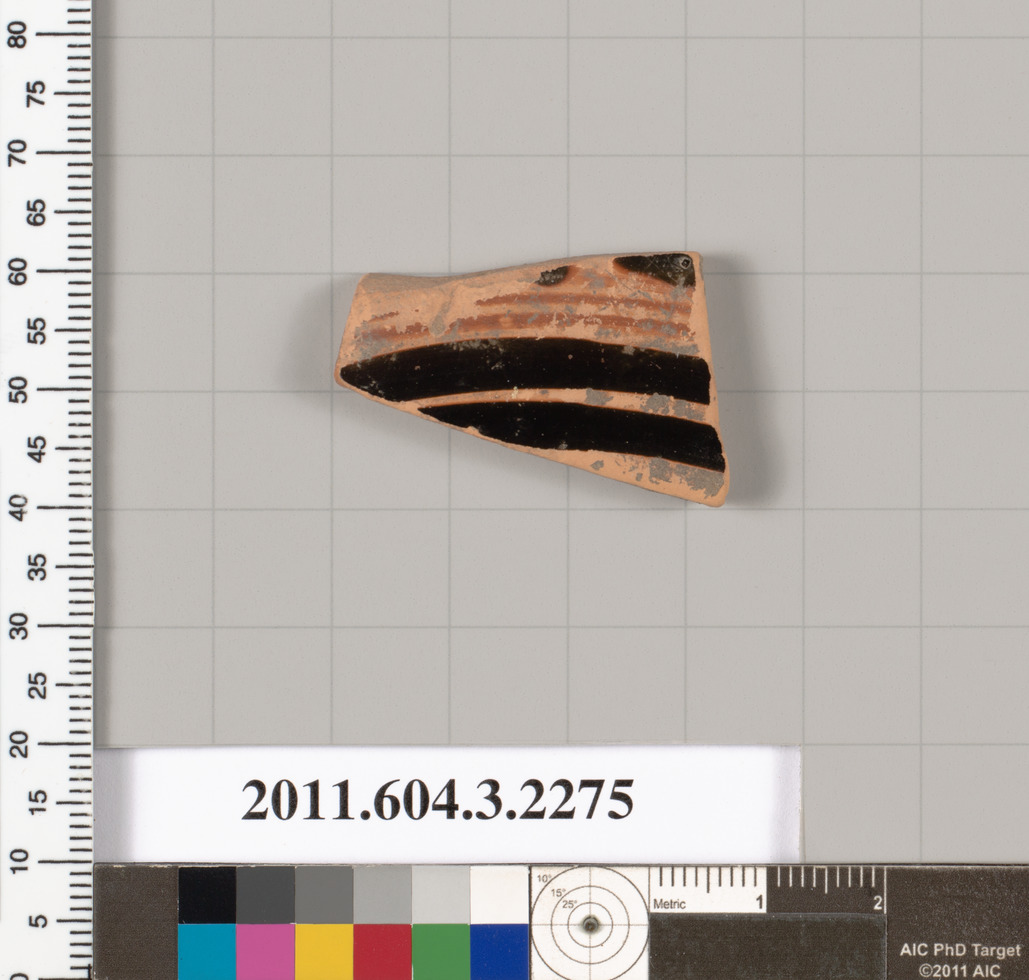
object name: kylix fragment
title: Terracotta fragment of a kylix (drinking cup)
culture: greek, attic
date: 600-401 BCE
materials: terracotta